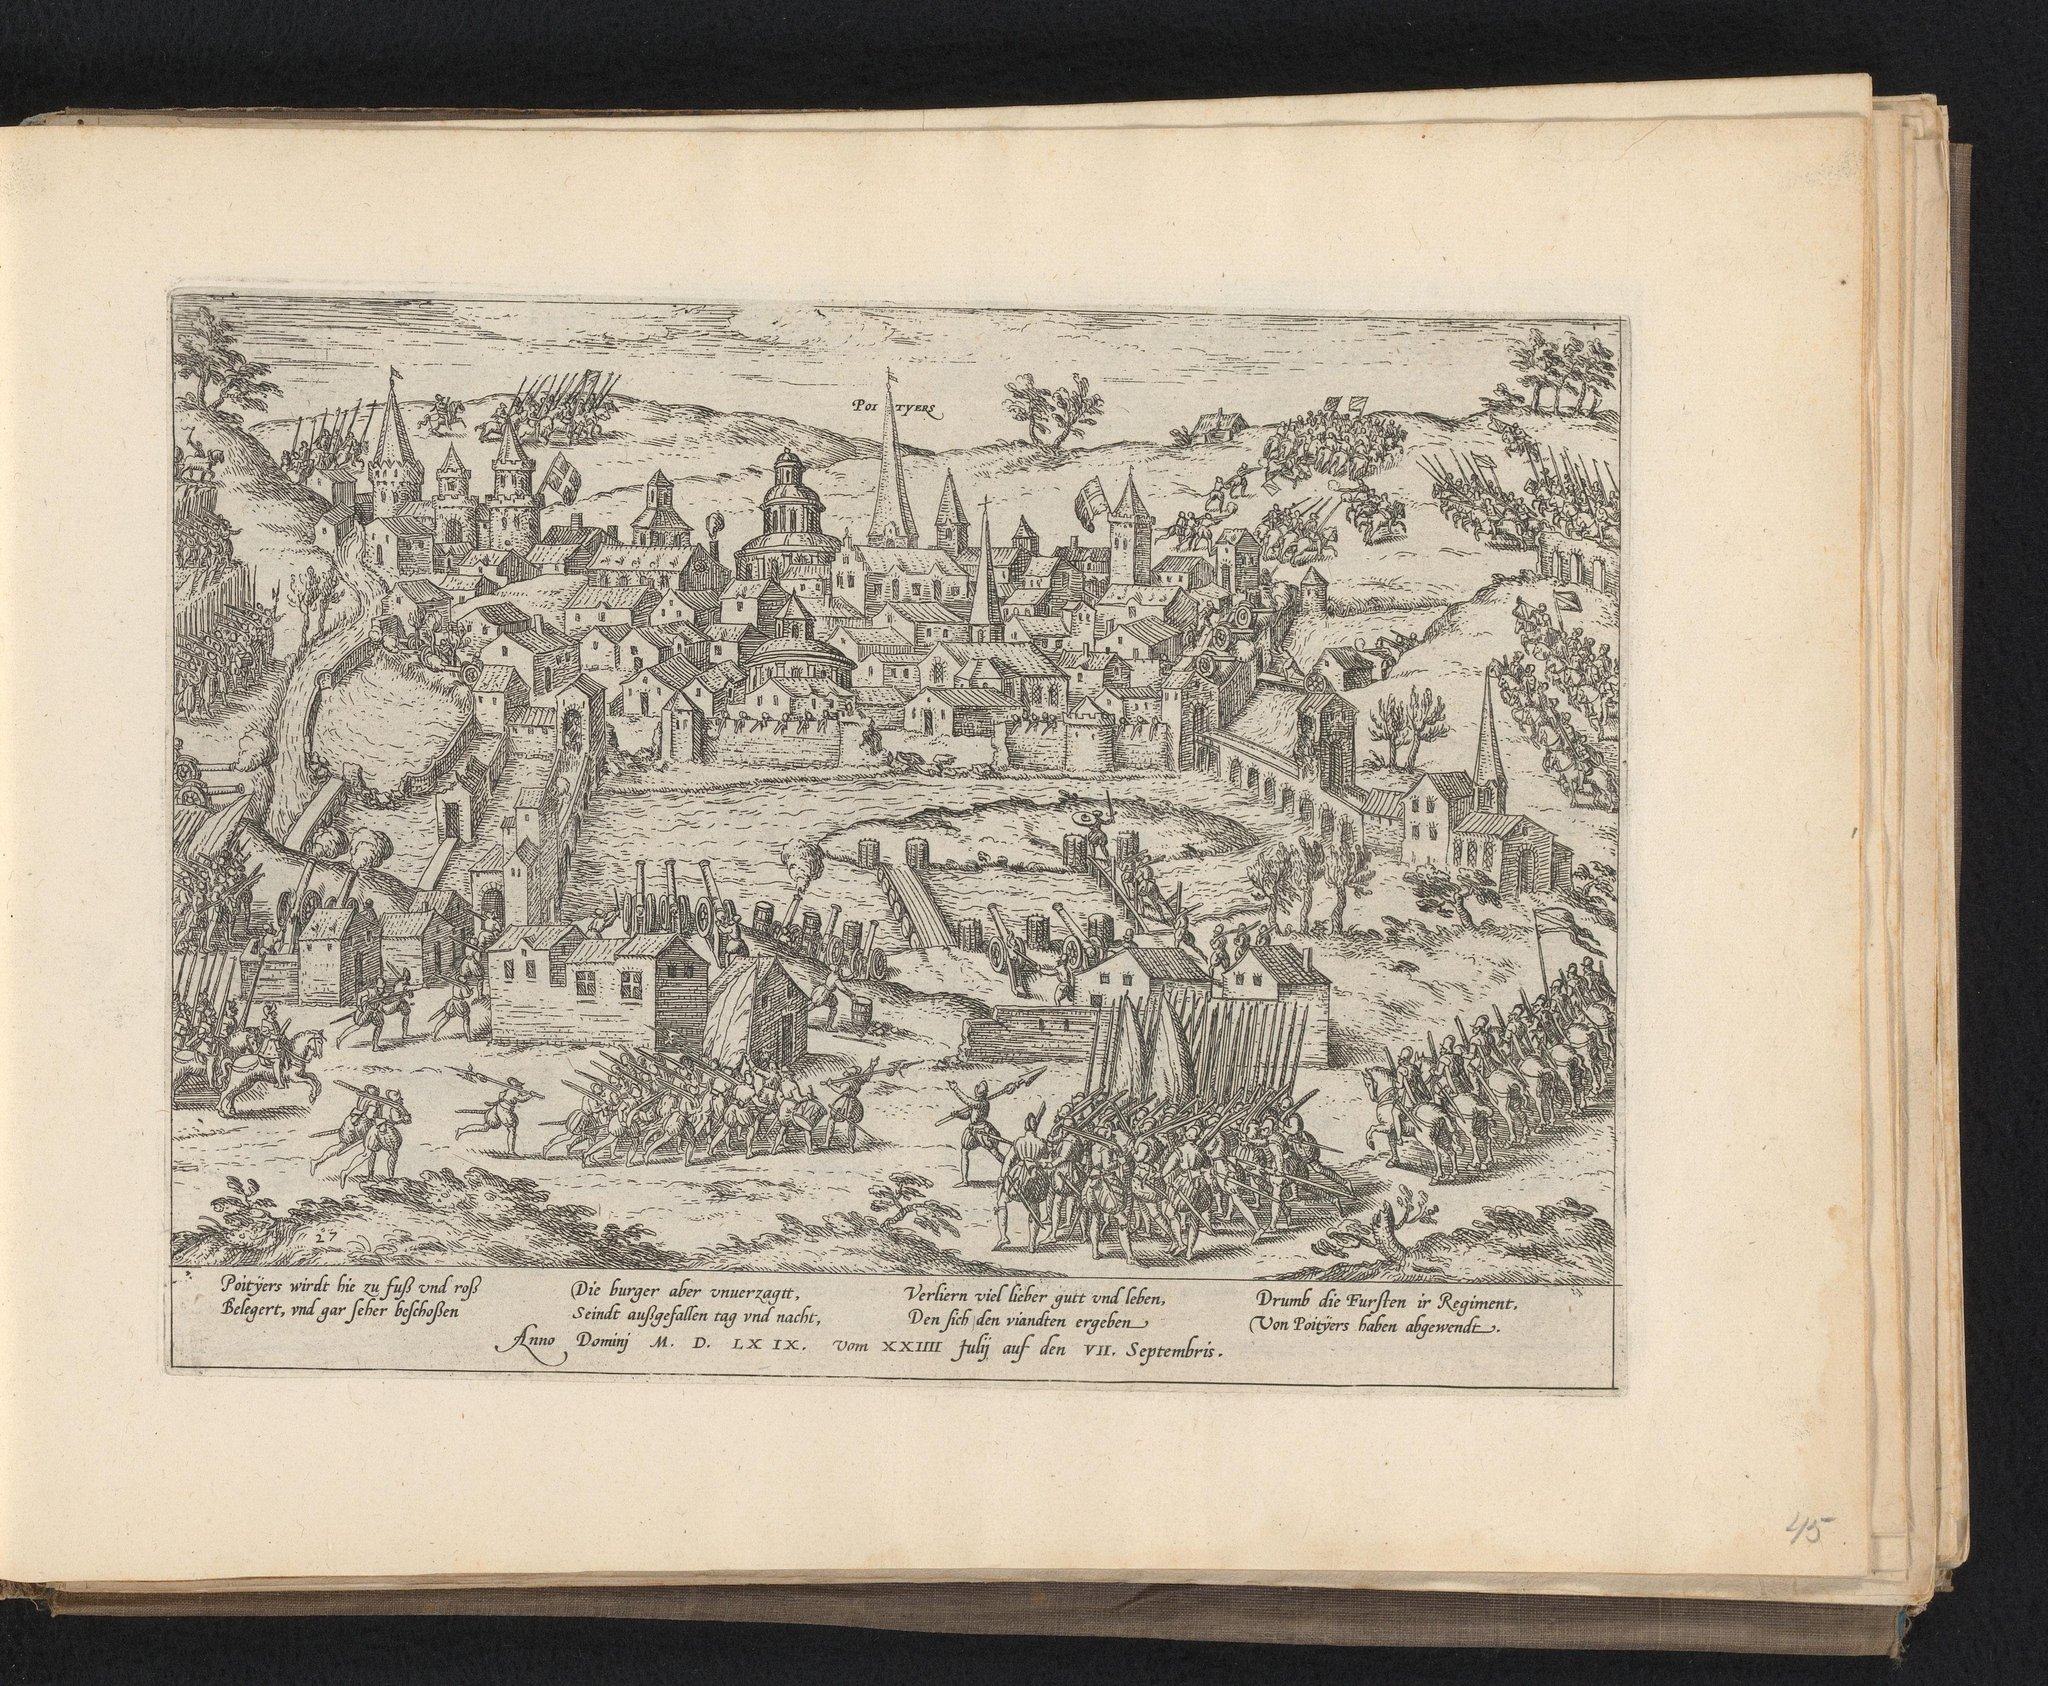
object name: album leaf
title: Beleg van Poitiers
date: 1569-1573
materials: paper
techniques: etching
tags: siege, position war, militant proselytizing: religious war, crusade, etc., the roman catholic church vs. protestantism; (reformation and counter reformation)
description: Prent gebruikt in: Aitsinger, Michael. De Leone Belgico (...). Keulen: s.n., 1588.